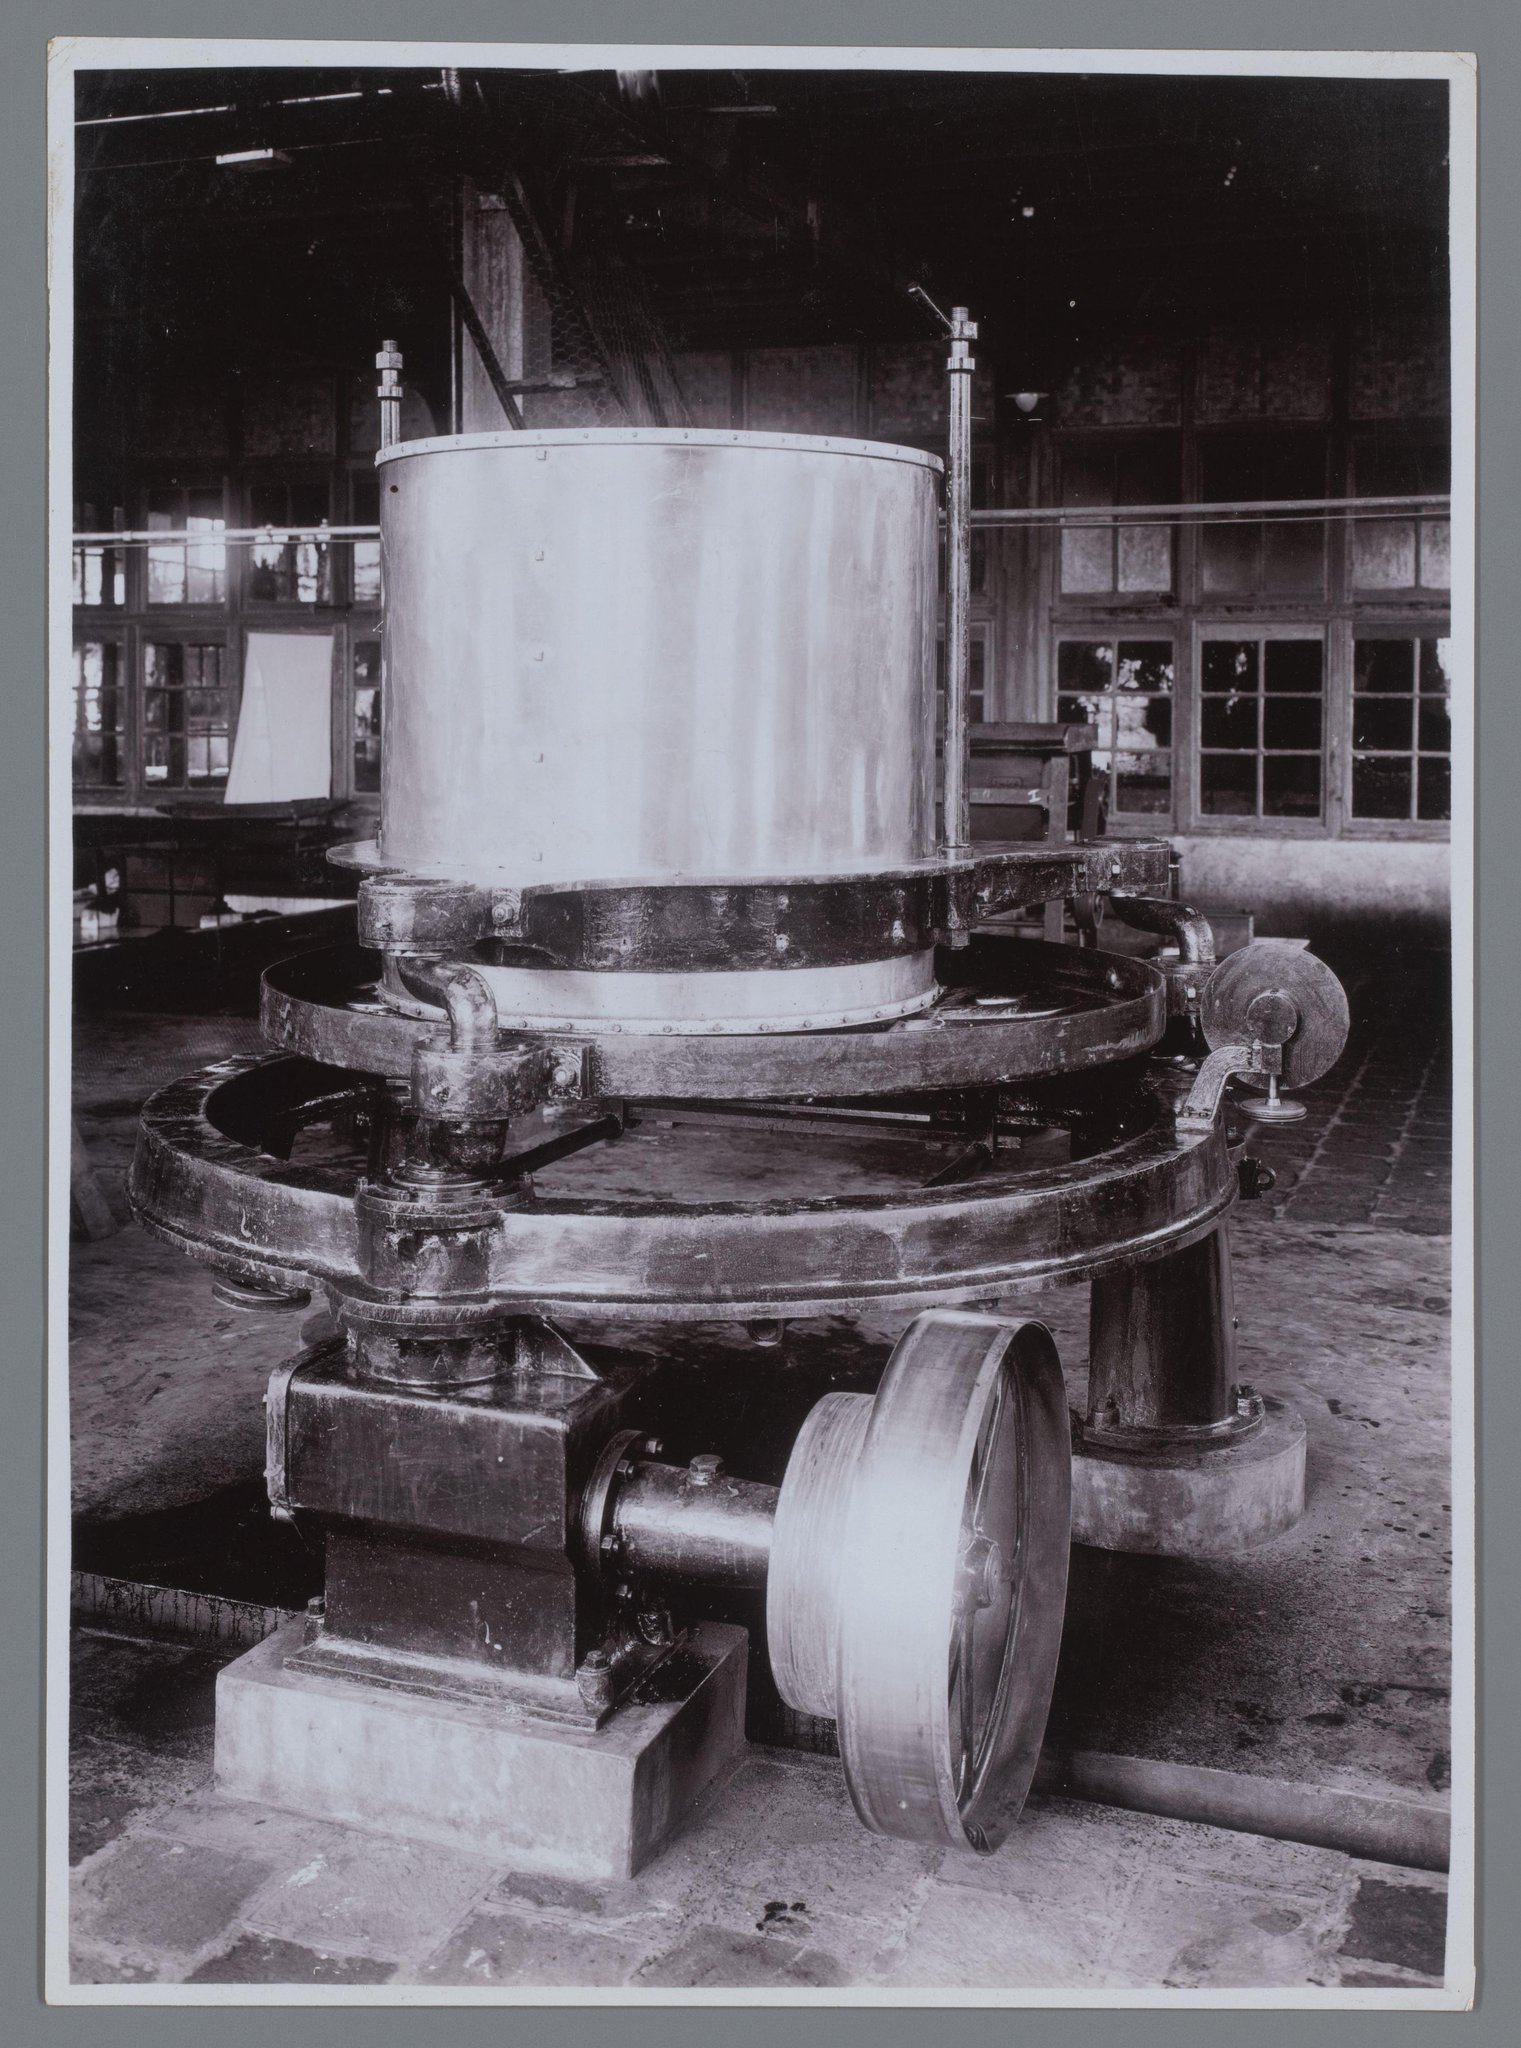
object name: photograph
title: Toproller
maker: Anonymous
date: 1931-1937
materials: photographic support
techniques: gelatin silver print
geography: java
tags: colonial system, factory-interior, machine shop, machines; parts of machines; tools and appliances, (non-fruit) products of plants or trees (with name), tea (leaves), java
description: Open toproller in de theefabriek Sinumbra op Java. Onderdeel van de multomap met foto's van machines van de N.V. Machinefabriek Braat te Soerabaja en Soekaboemi bestemd voor de Nederlandse theeindustrie op Java en Sumatra, uit de periode 1931-1937.